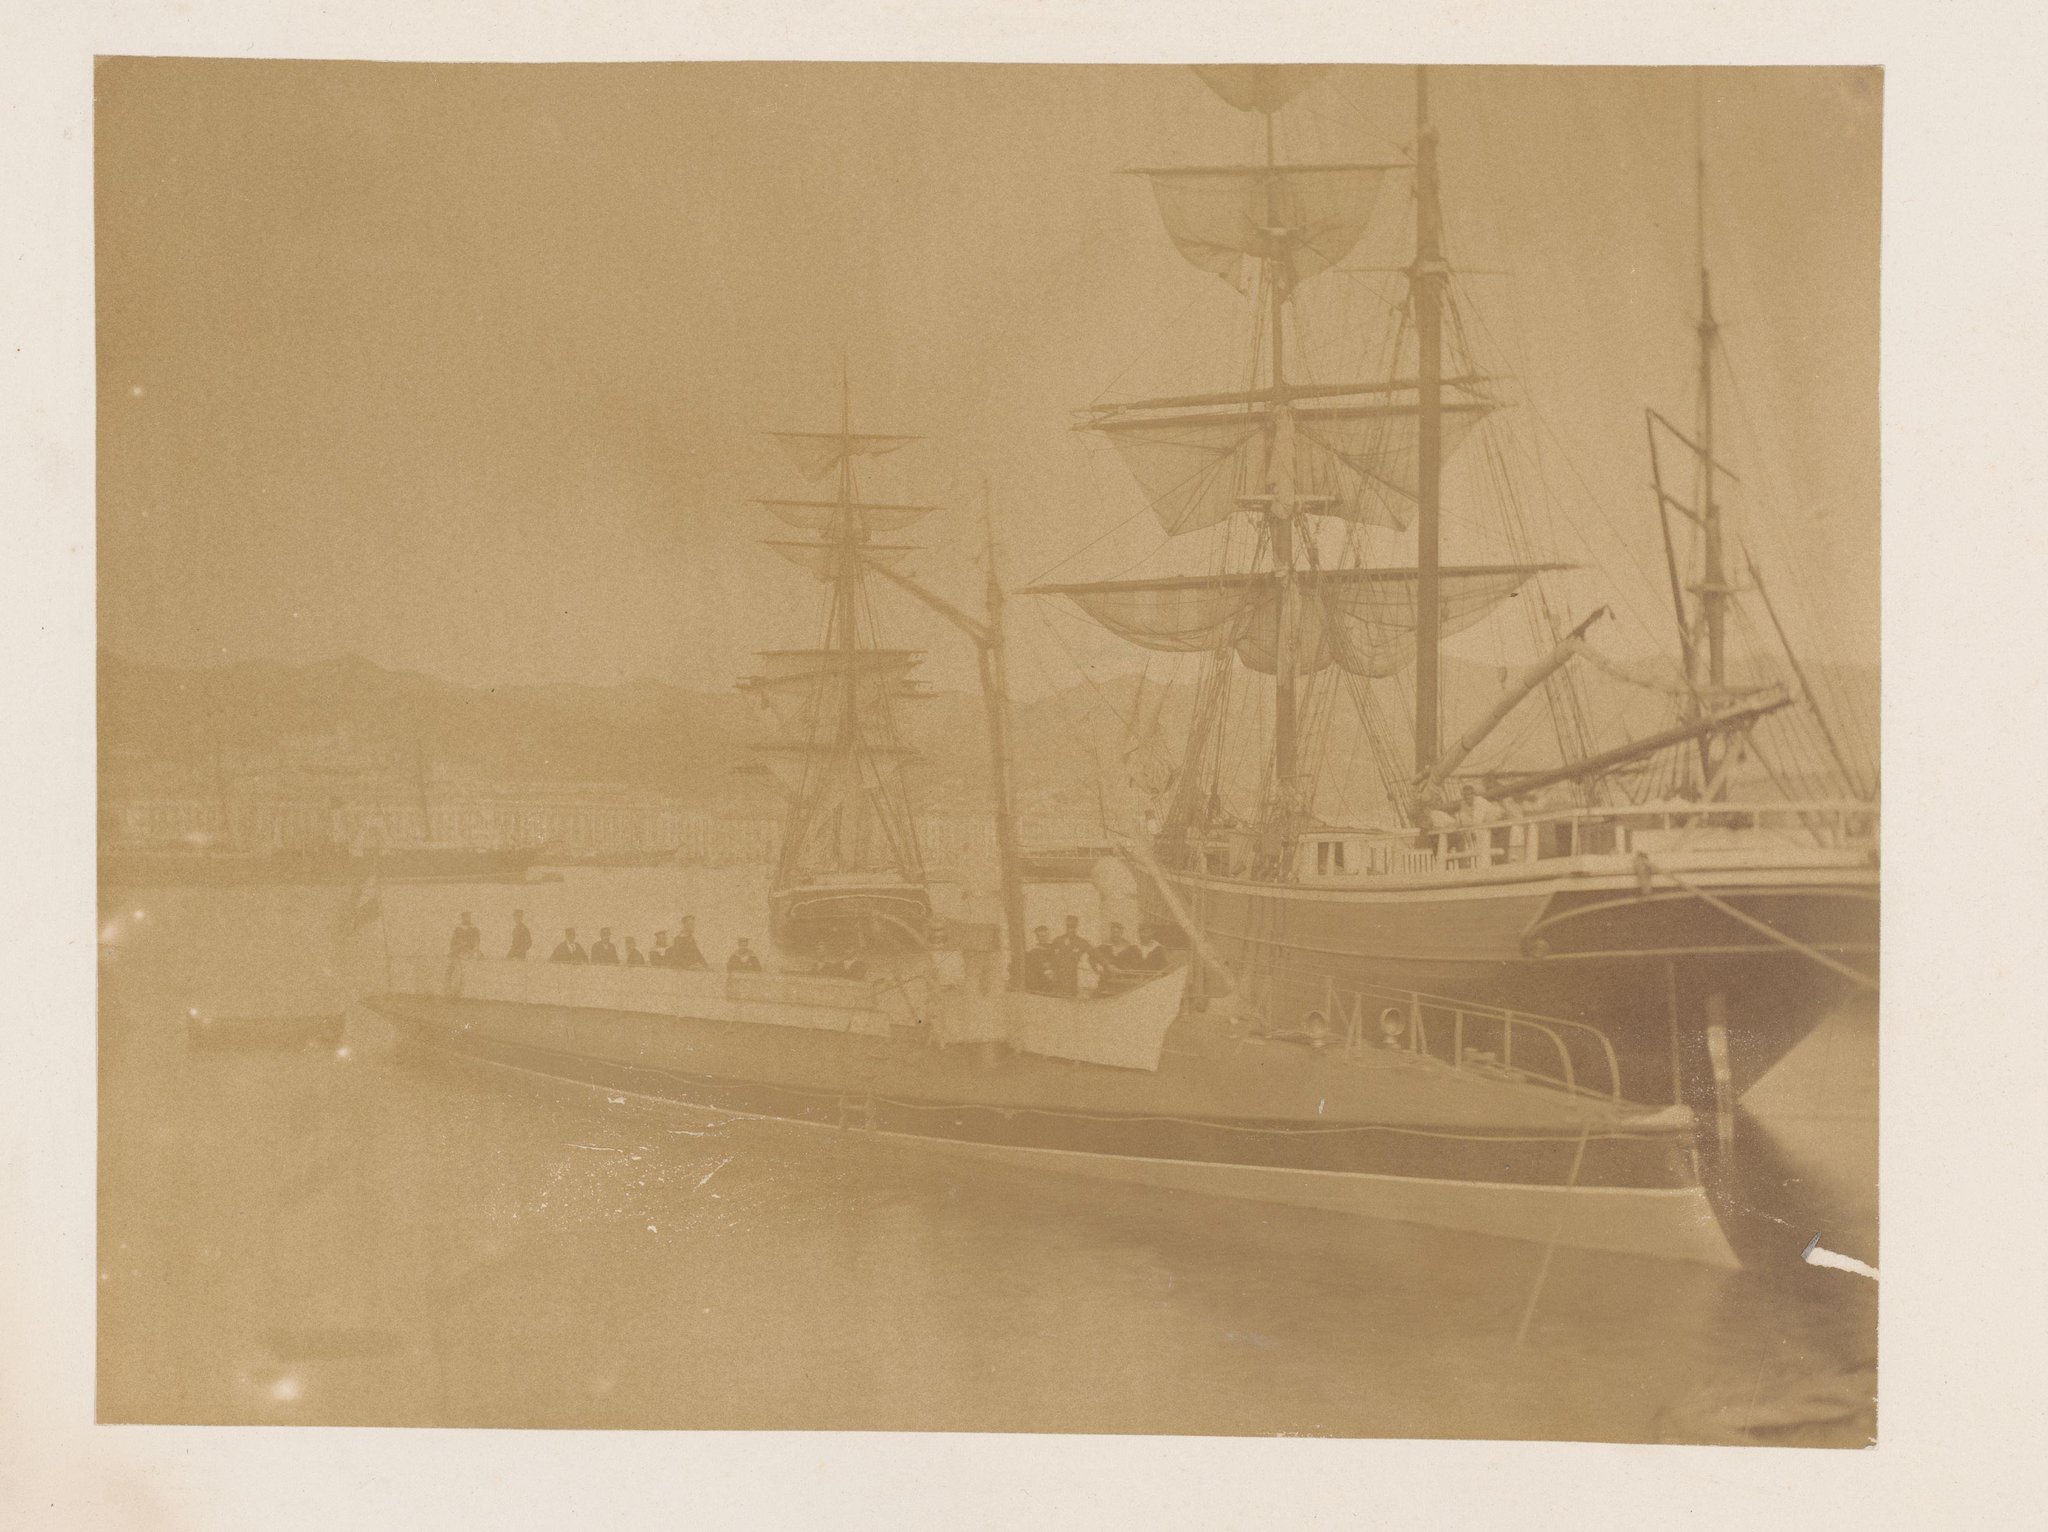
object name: photograph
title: Twee opleidingsschepen in de haven met matrozen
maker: Anonymous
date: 1880-1900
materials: cardboard, paper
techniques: albumen print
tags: harbour